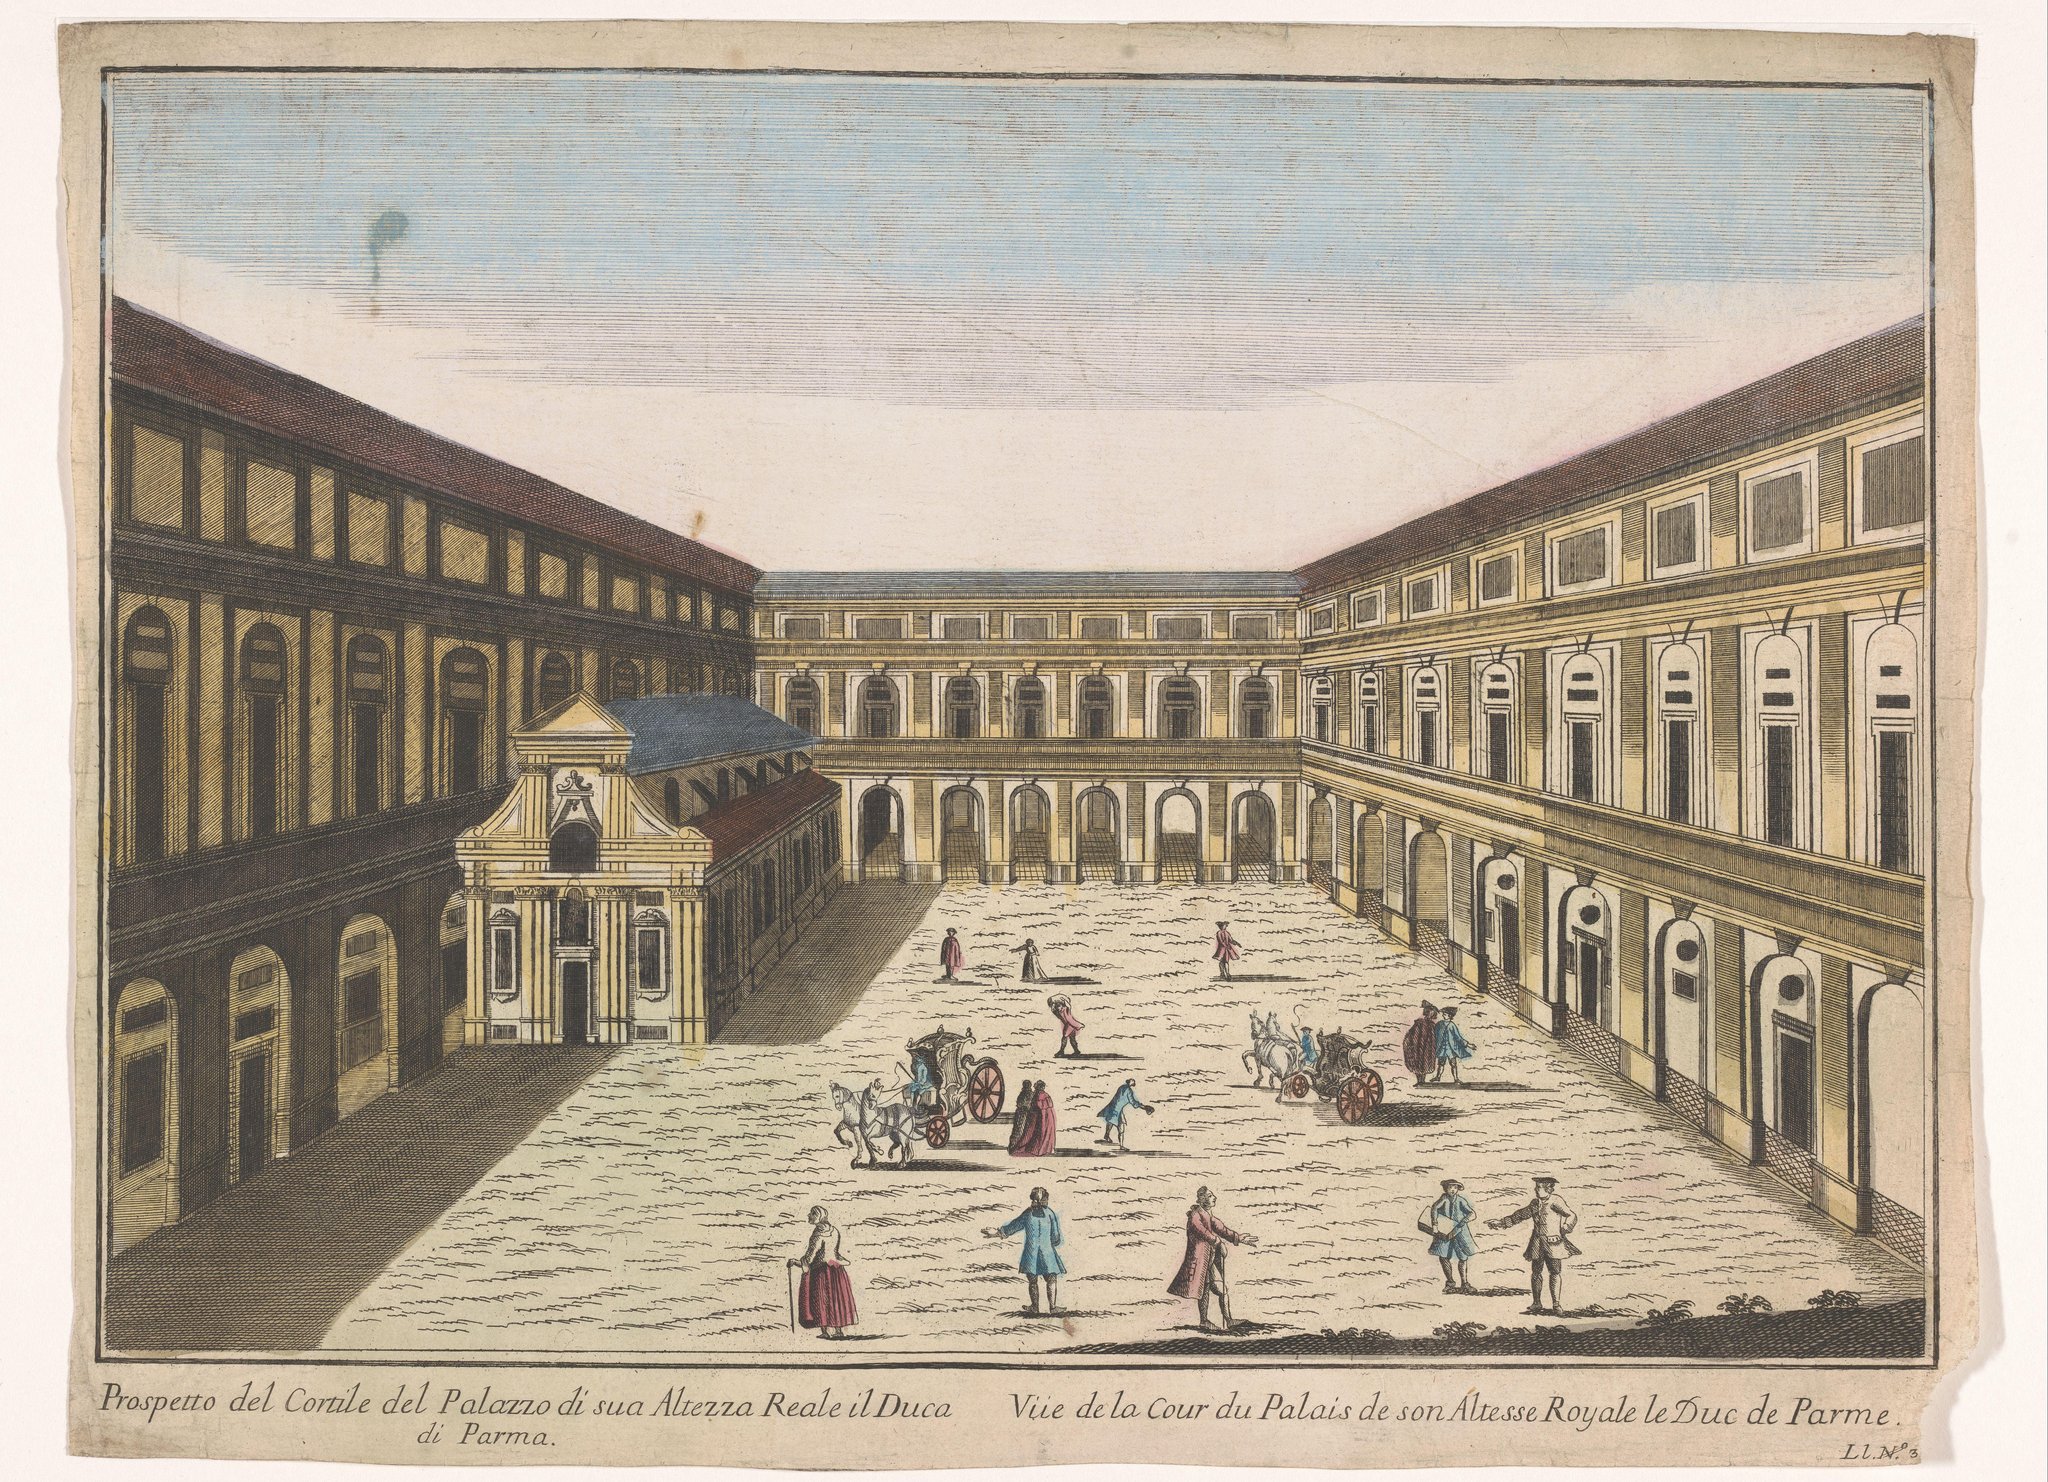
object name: opticaprent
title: Prospetto del cortile del palazzo di sua altezza reale il duca di Parma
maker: Anonymous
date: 1700-1799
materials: paper, watercolor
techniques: brush, etching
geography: bassano del grappa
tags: inner court of palace or 'hôtel'